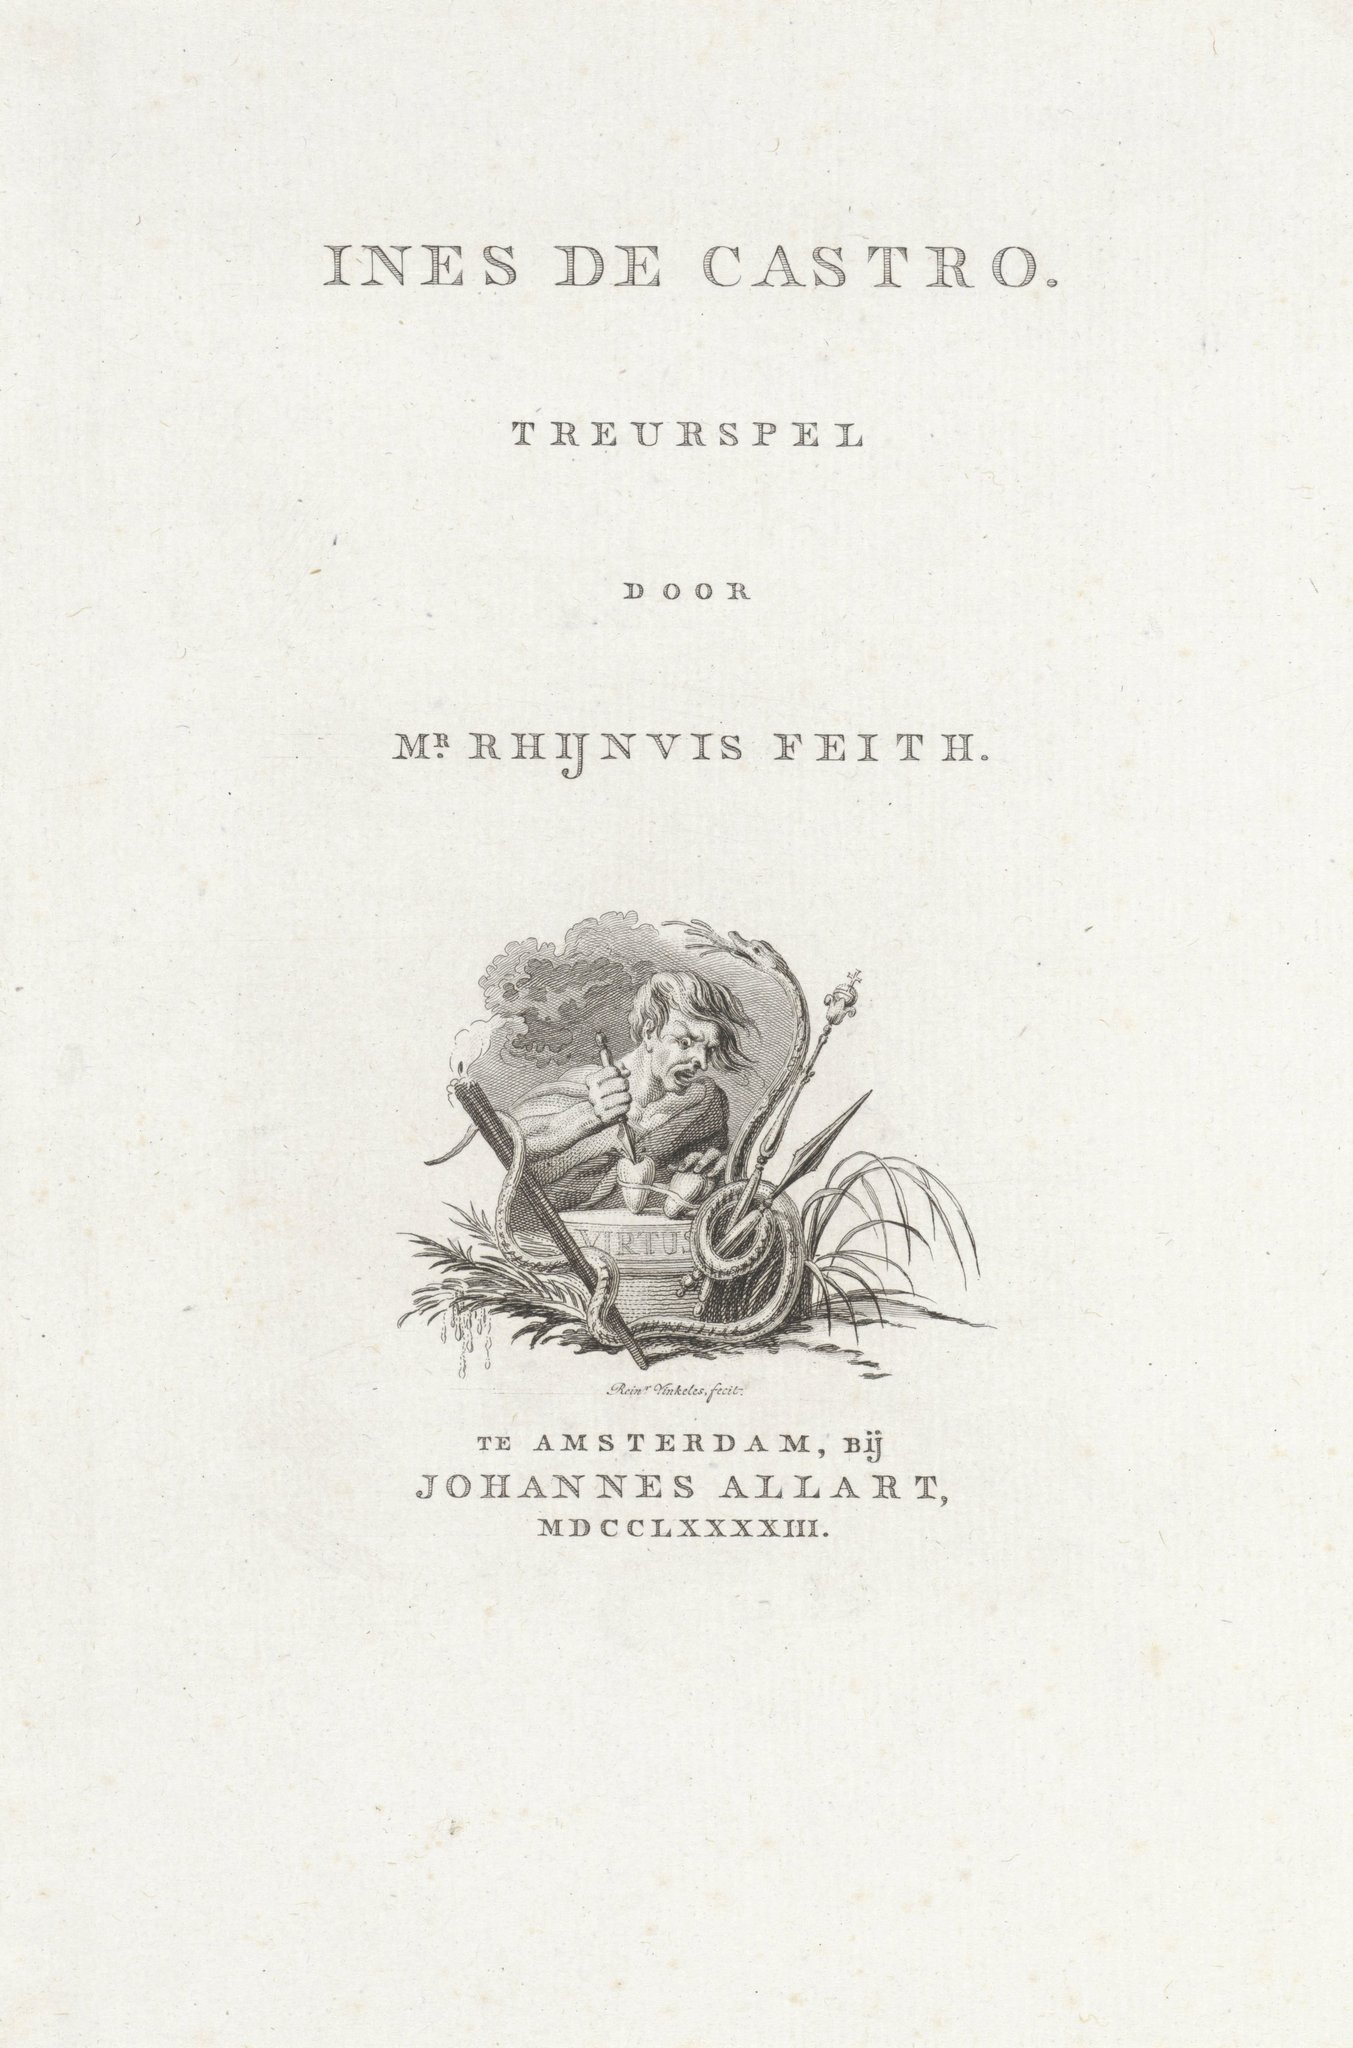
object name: titelblad, titelpagina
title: Titelprent voor: Rhijnvis Feith, 'Ines de Castro', 1793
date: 1793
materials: paper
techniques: engraving, etching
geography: amsterdam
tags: snakes, envy; 'invidia' (ripa) ~ personification of one of the seven deadly sins, candle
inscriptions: collector's mark: Lugt 240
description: Titelpagina voor: Feith, Rhijnvis. Ines de Castro. Amsterdam: Johannes Allart, 1793.